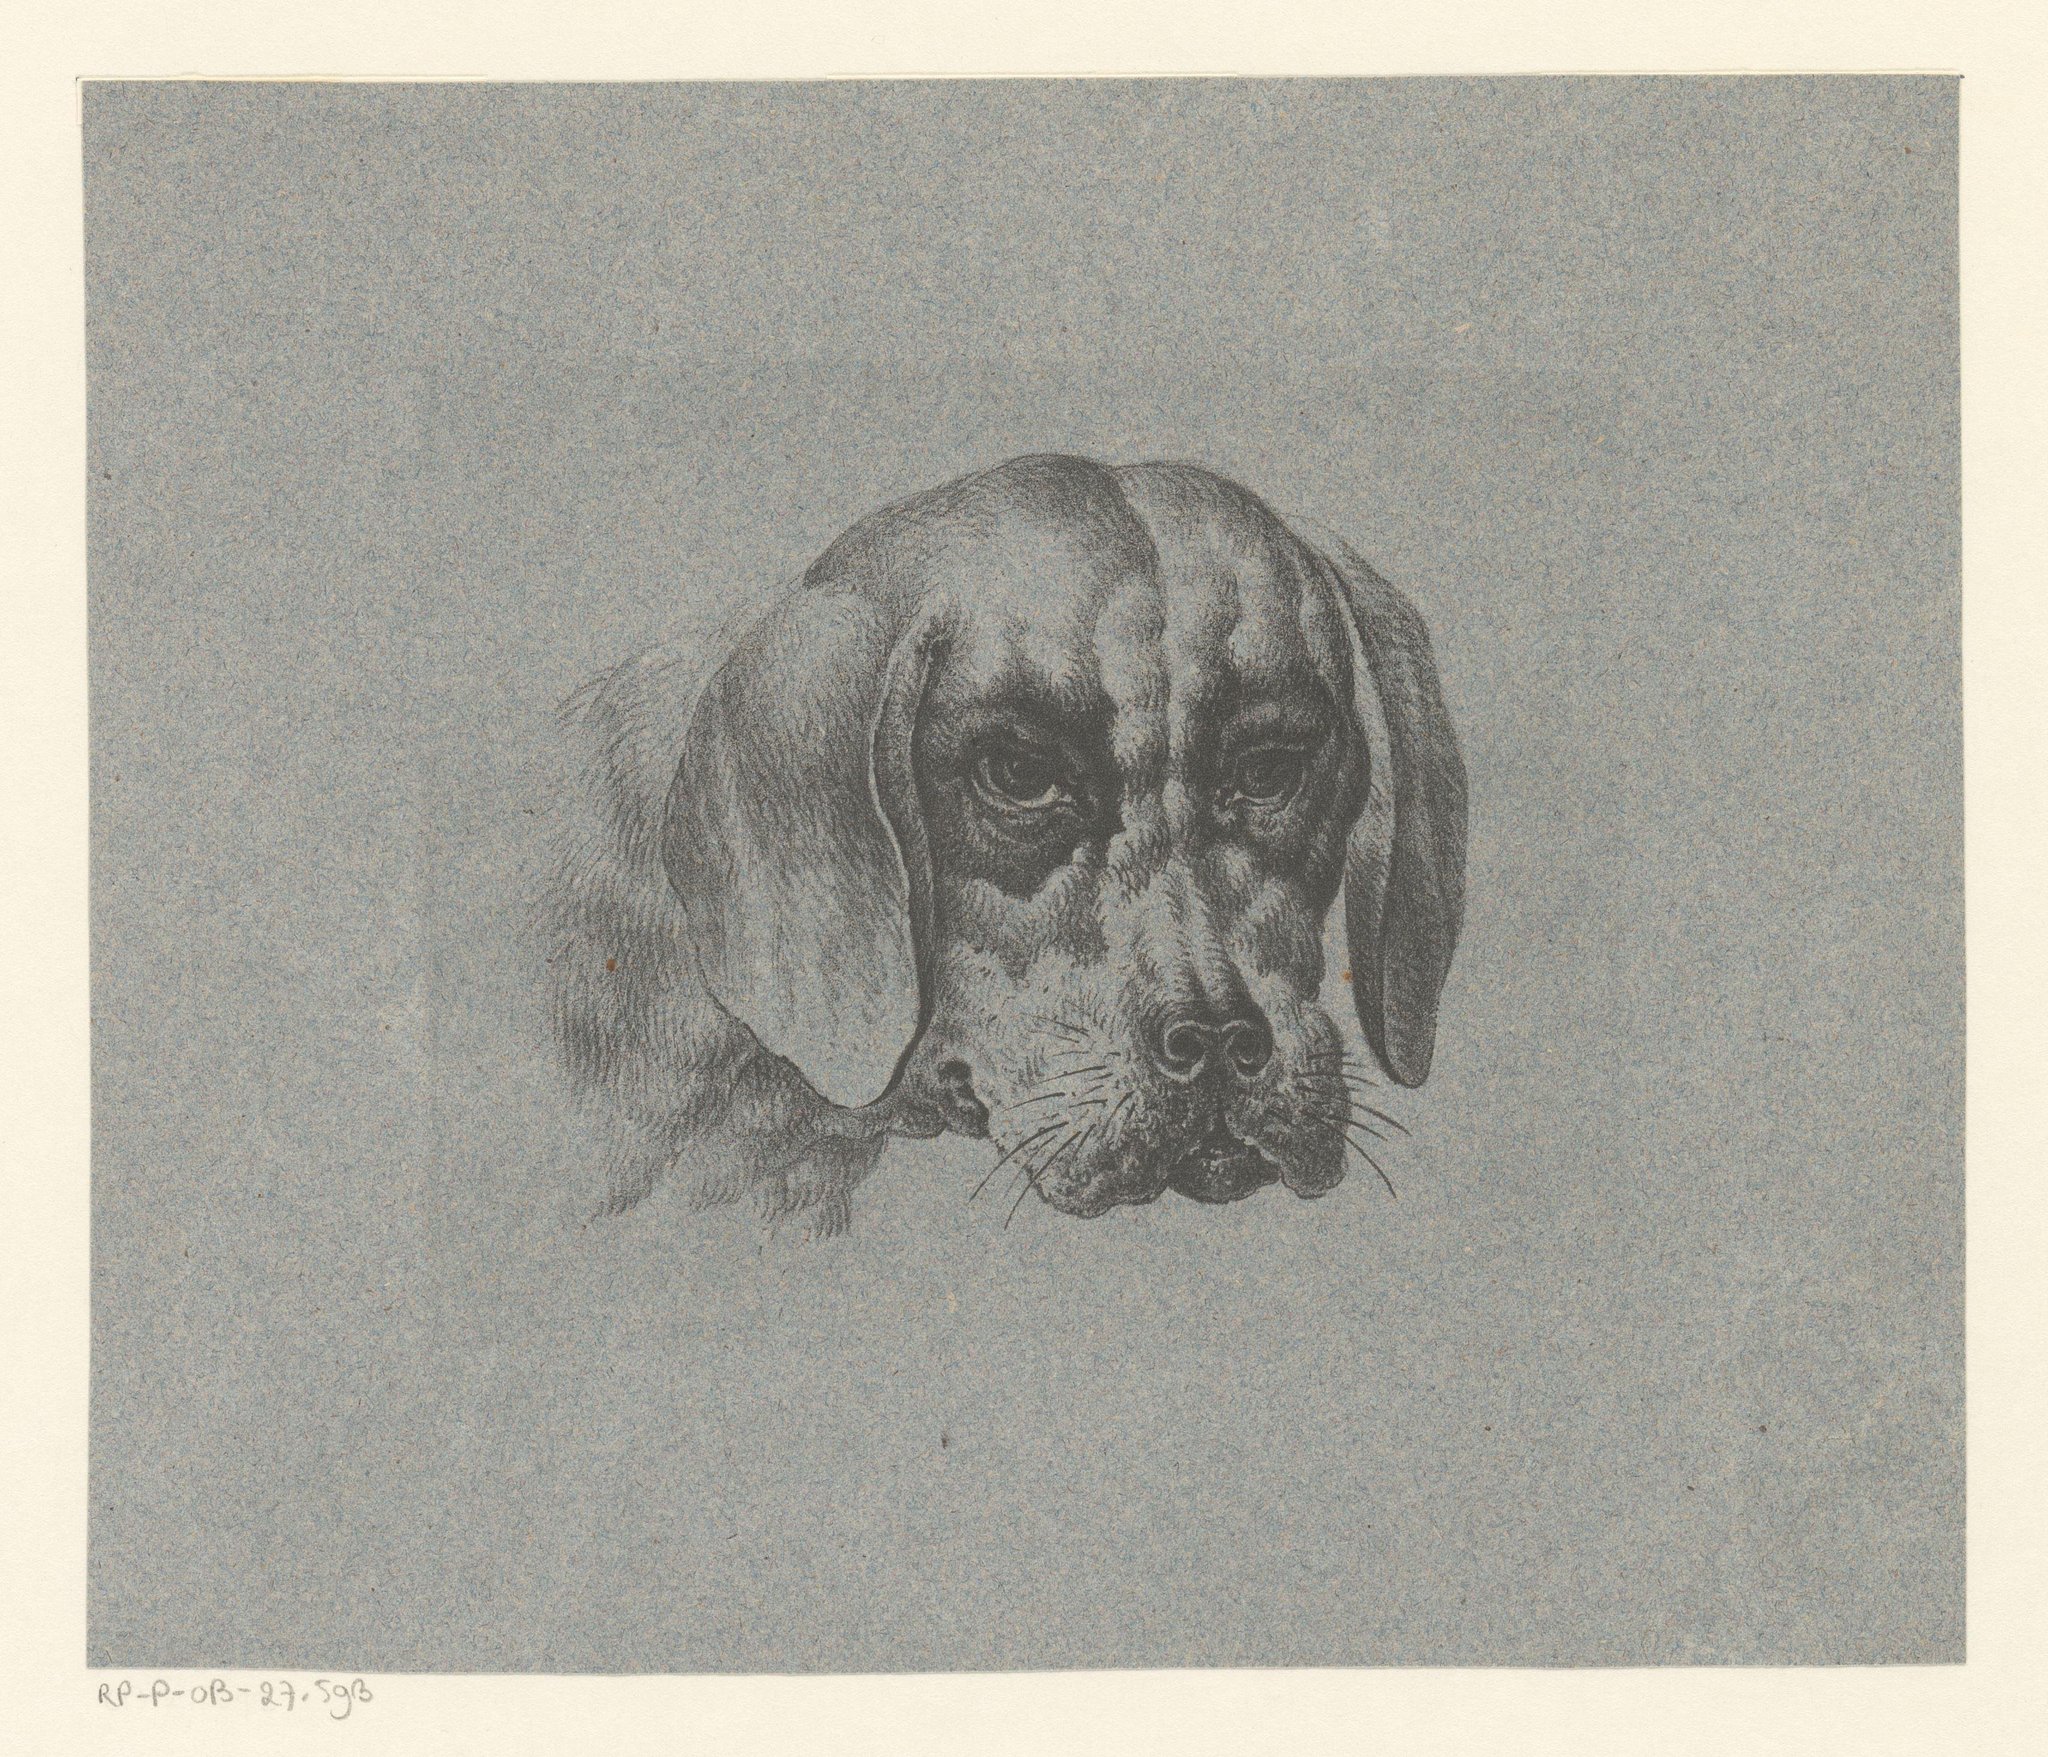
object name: print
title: Hondenkop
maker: pieter bartholomeusz. barbiers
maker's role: draughtsman, print maker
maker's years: 1772-1837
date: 1809-1837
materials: paper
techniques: lithograph, lithography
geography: haarlem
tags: dog (+ head of an animal)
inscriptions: collector's mark: Lugt 2228